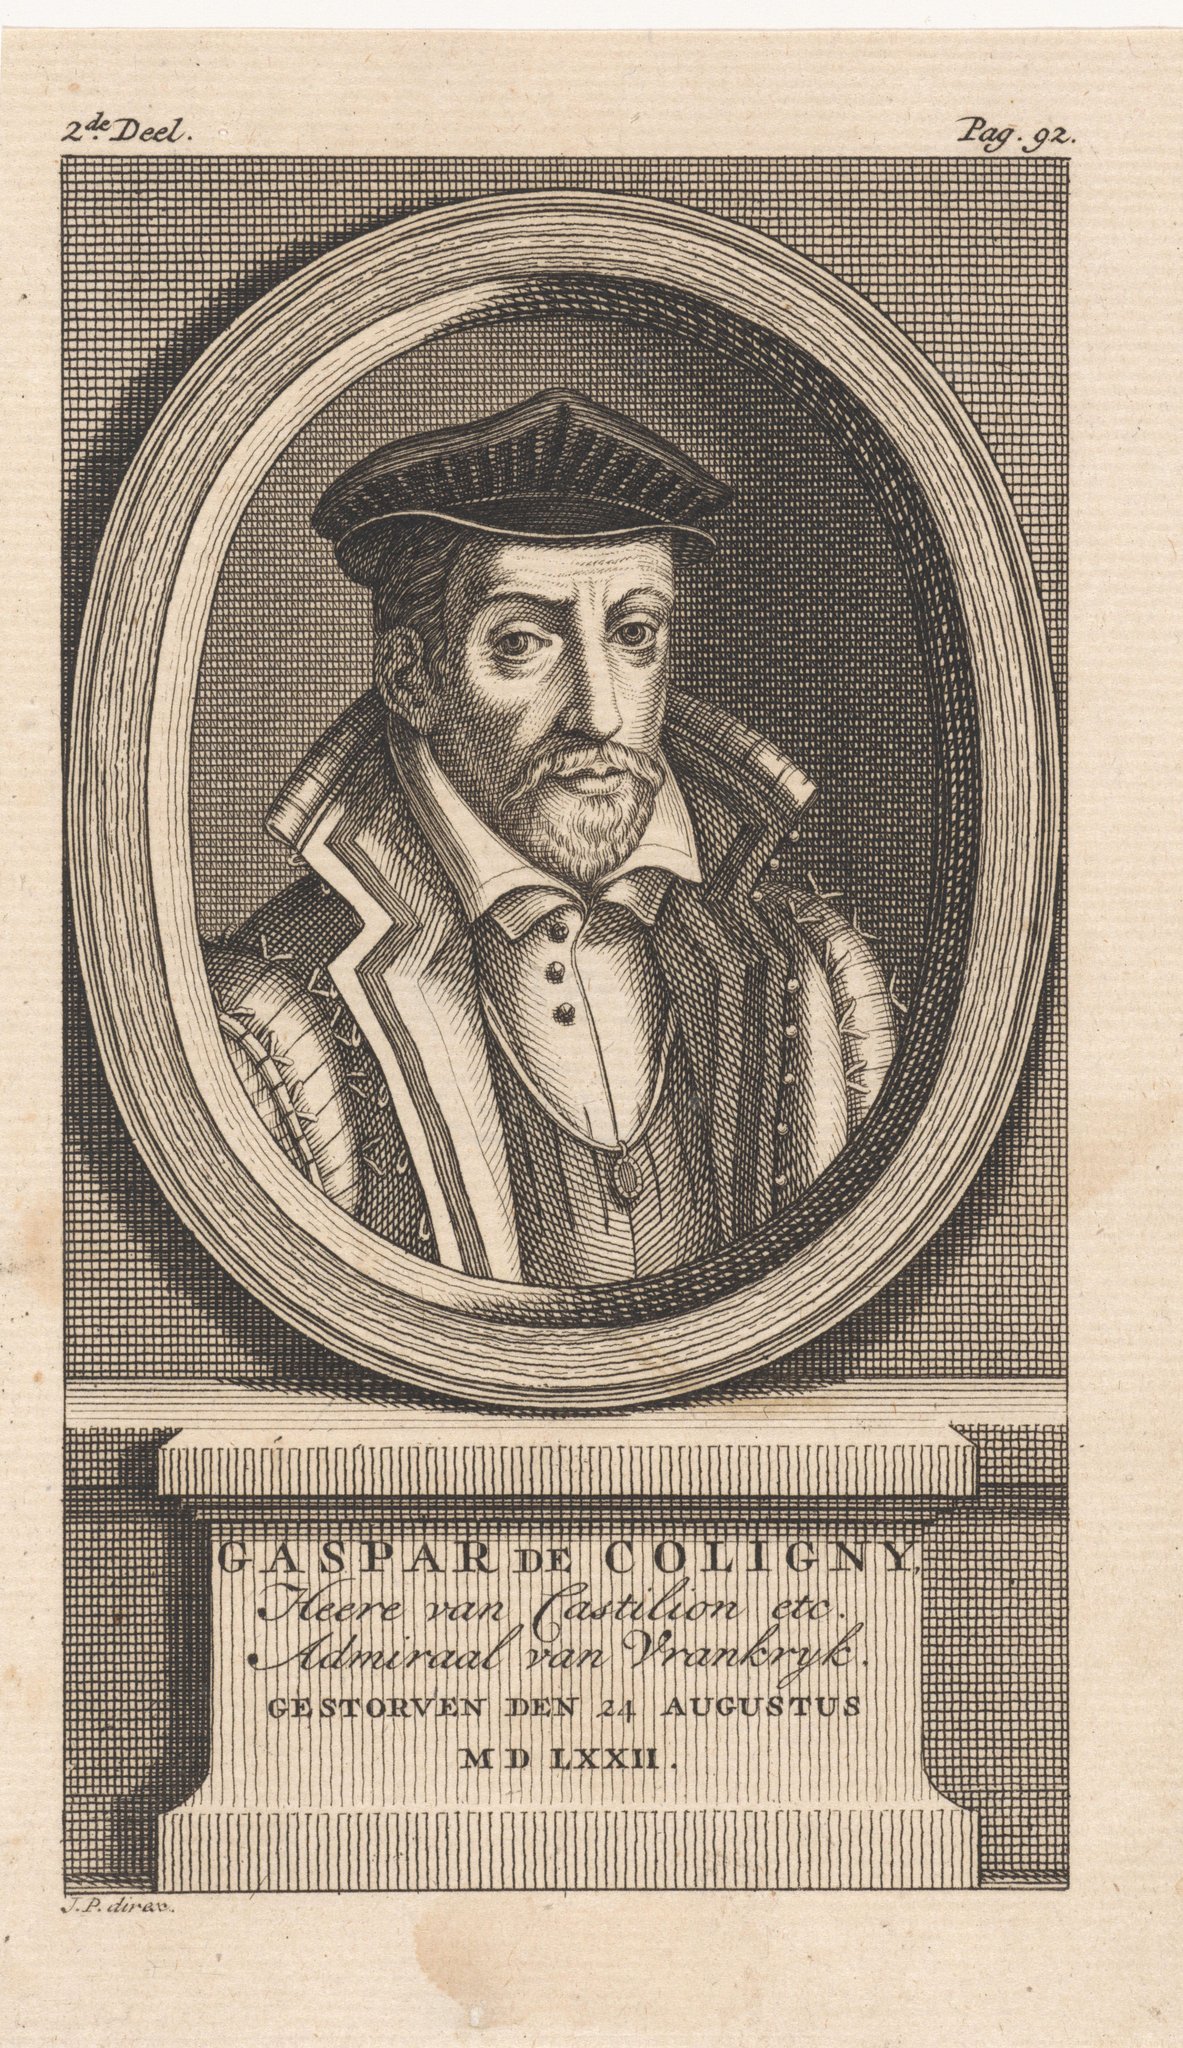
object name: book illustration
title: Portret van Gaspard de Coligny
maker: jan punt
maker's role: draughtsman, print maker, publisher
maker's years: 1711-1779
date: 1749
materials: paper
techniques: engraving, etching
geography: northern netherlands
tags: paris, politician, gaspard de coligny (ii)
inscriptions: collector's mark: Lugt 2228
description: Prent gebruikt als illustratie in: Meteren, Emanuel van. Historie van de oorlogen en geschiedenissen der Nederlanderen, en der zelver naburen: beginnende met den jare 1315, en eindigende met den jare 1611, deel II, p. 92. Gorinchem/Breda: Nicolaas Goetzee/Willem Goetzee, 1749.